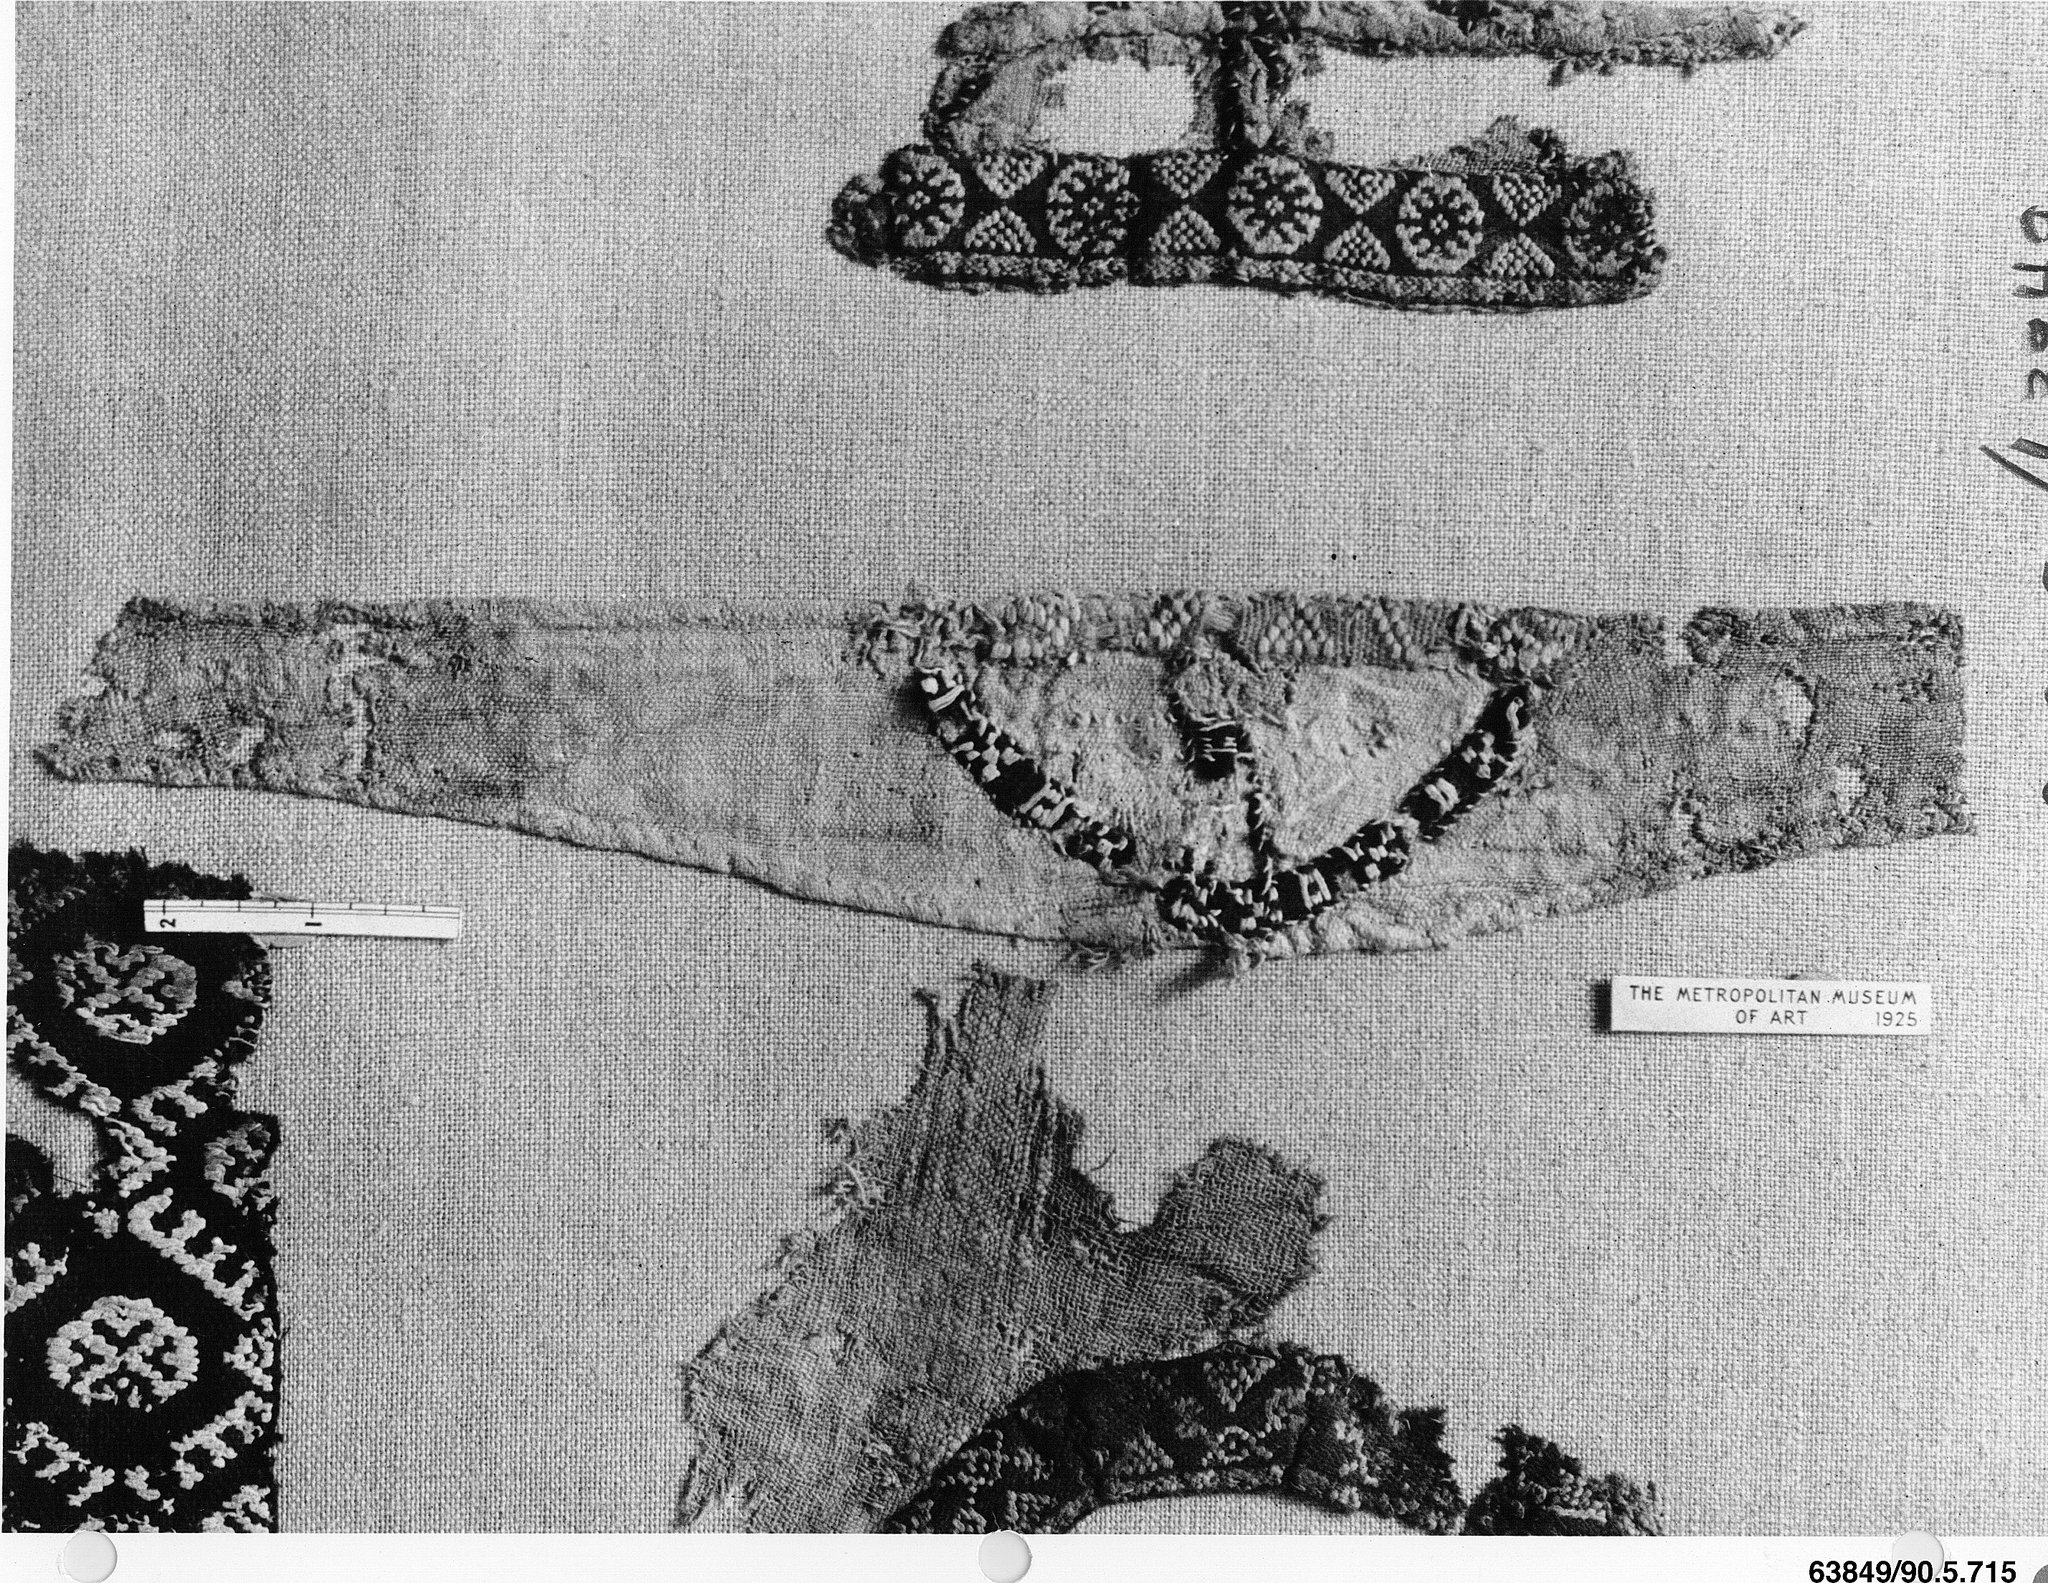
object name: textile fragment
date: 401-600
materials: linen, wool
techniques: weave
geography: egypt